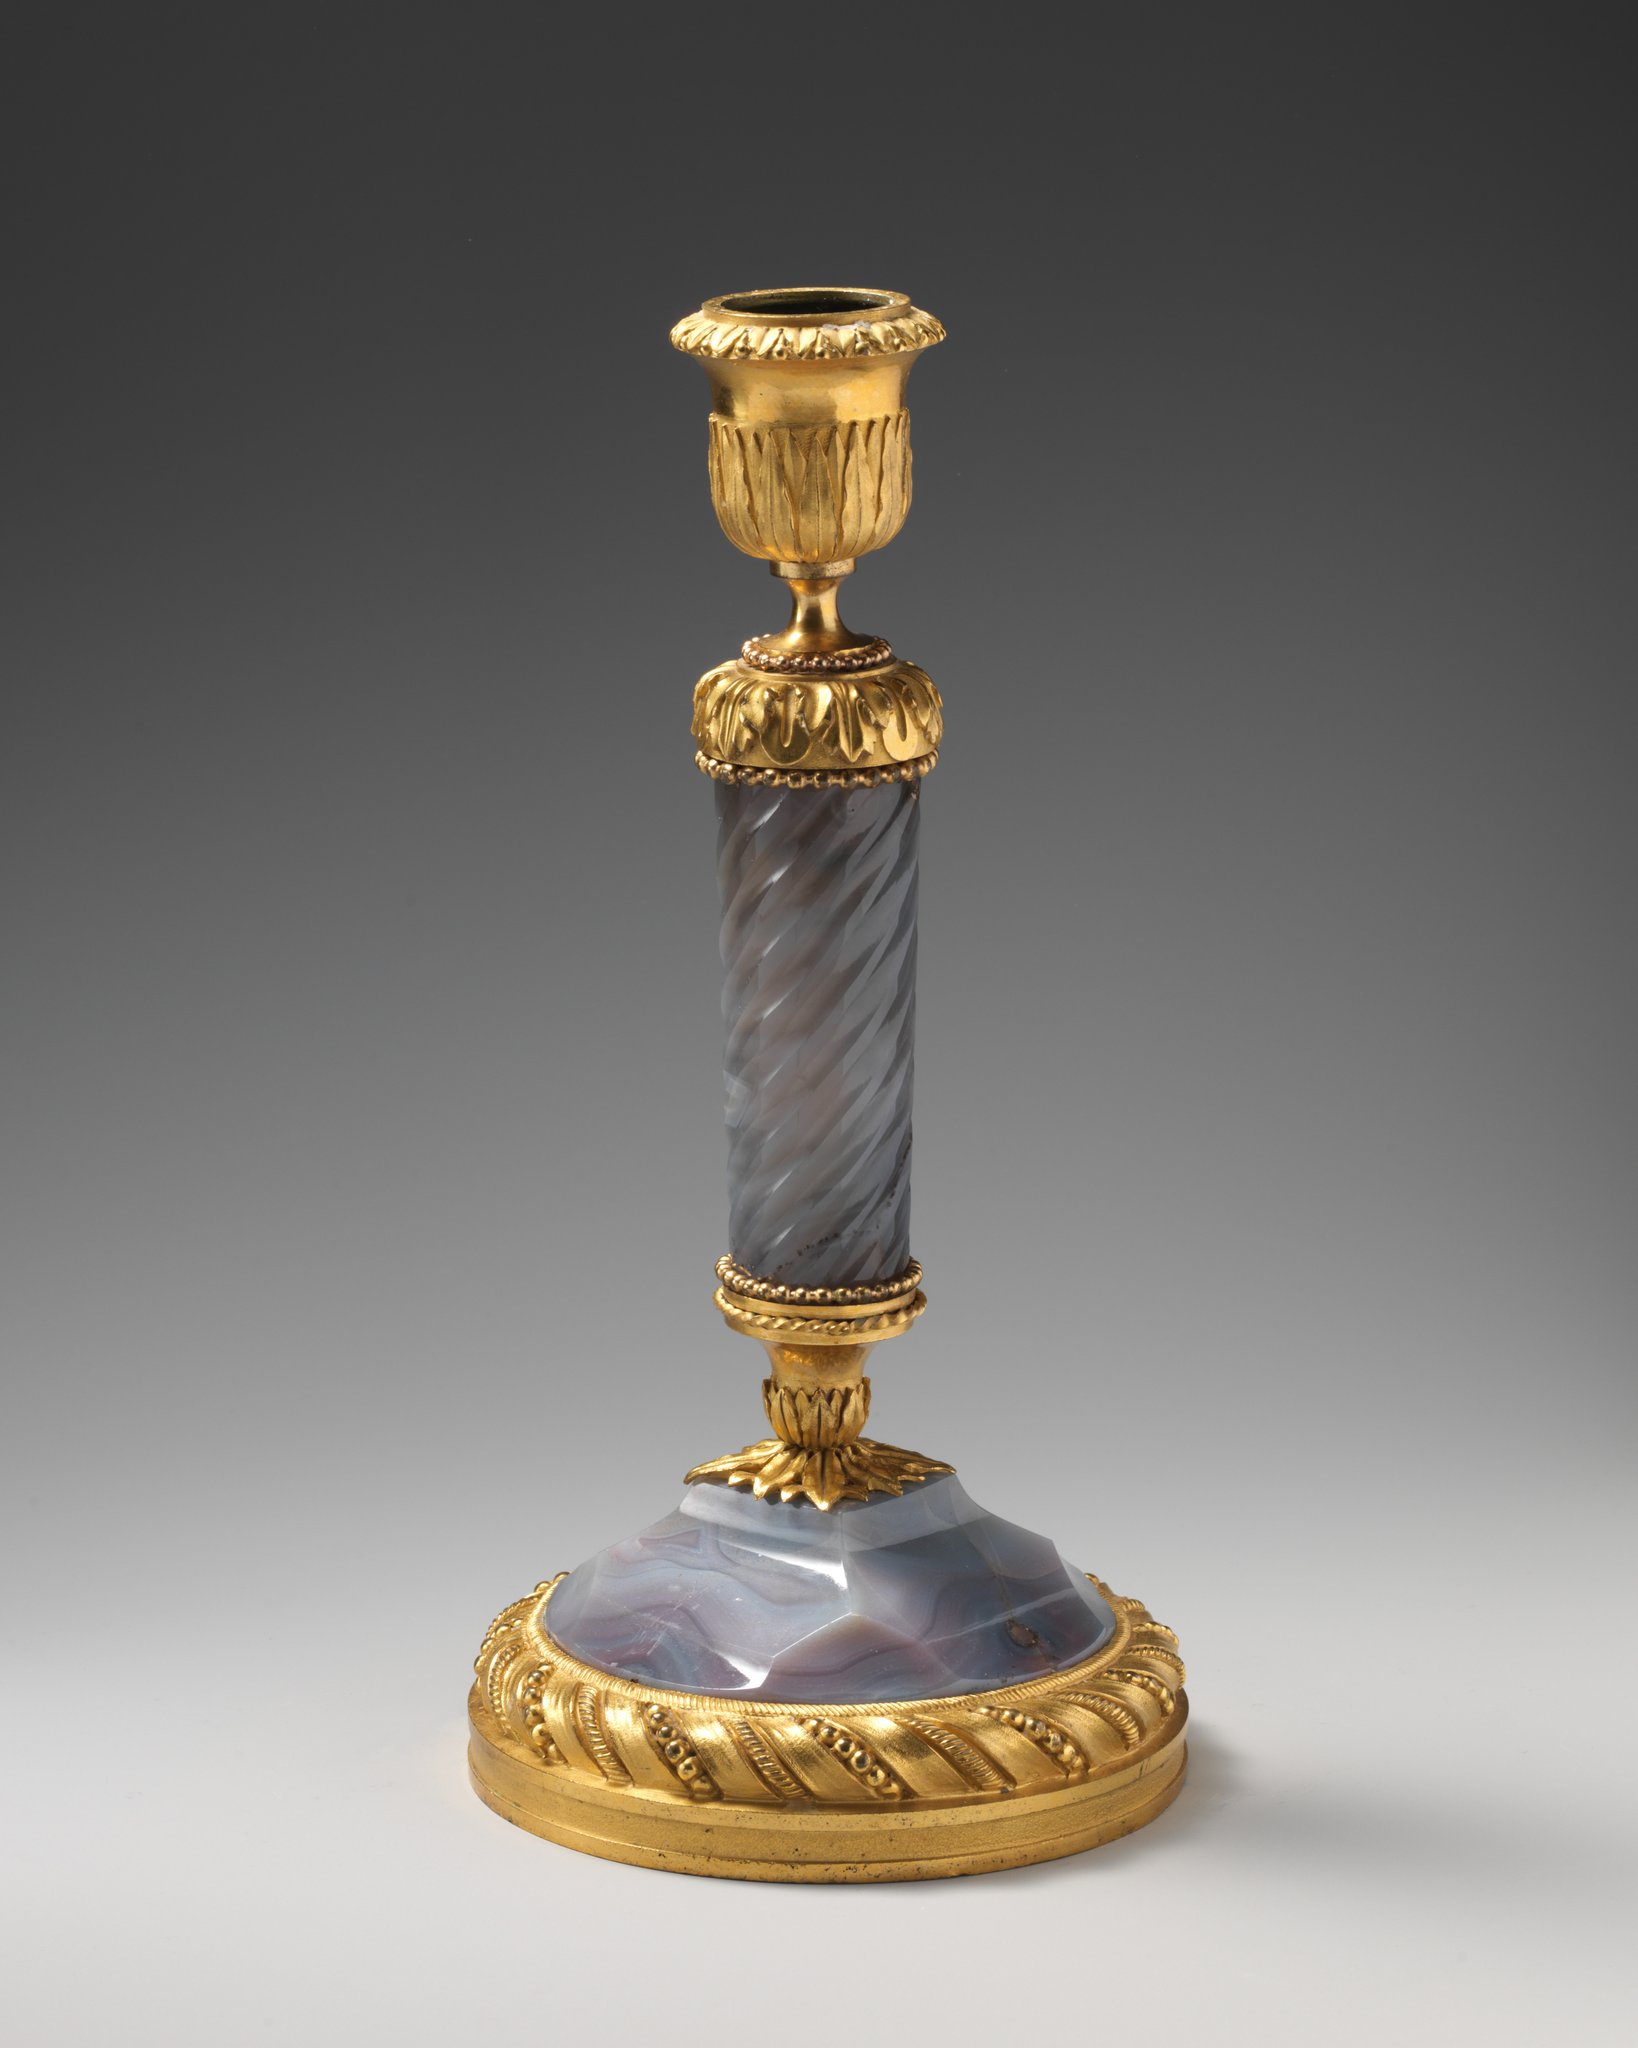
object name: candlestick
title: Candlestick (one of a pair)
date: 1775-1790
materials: stone, gilt bronze